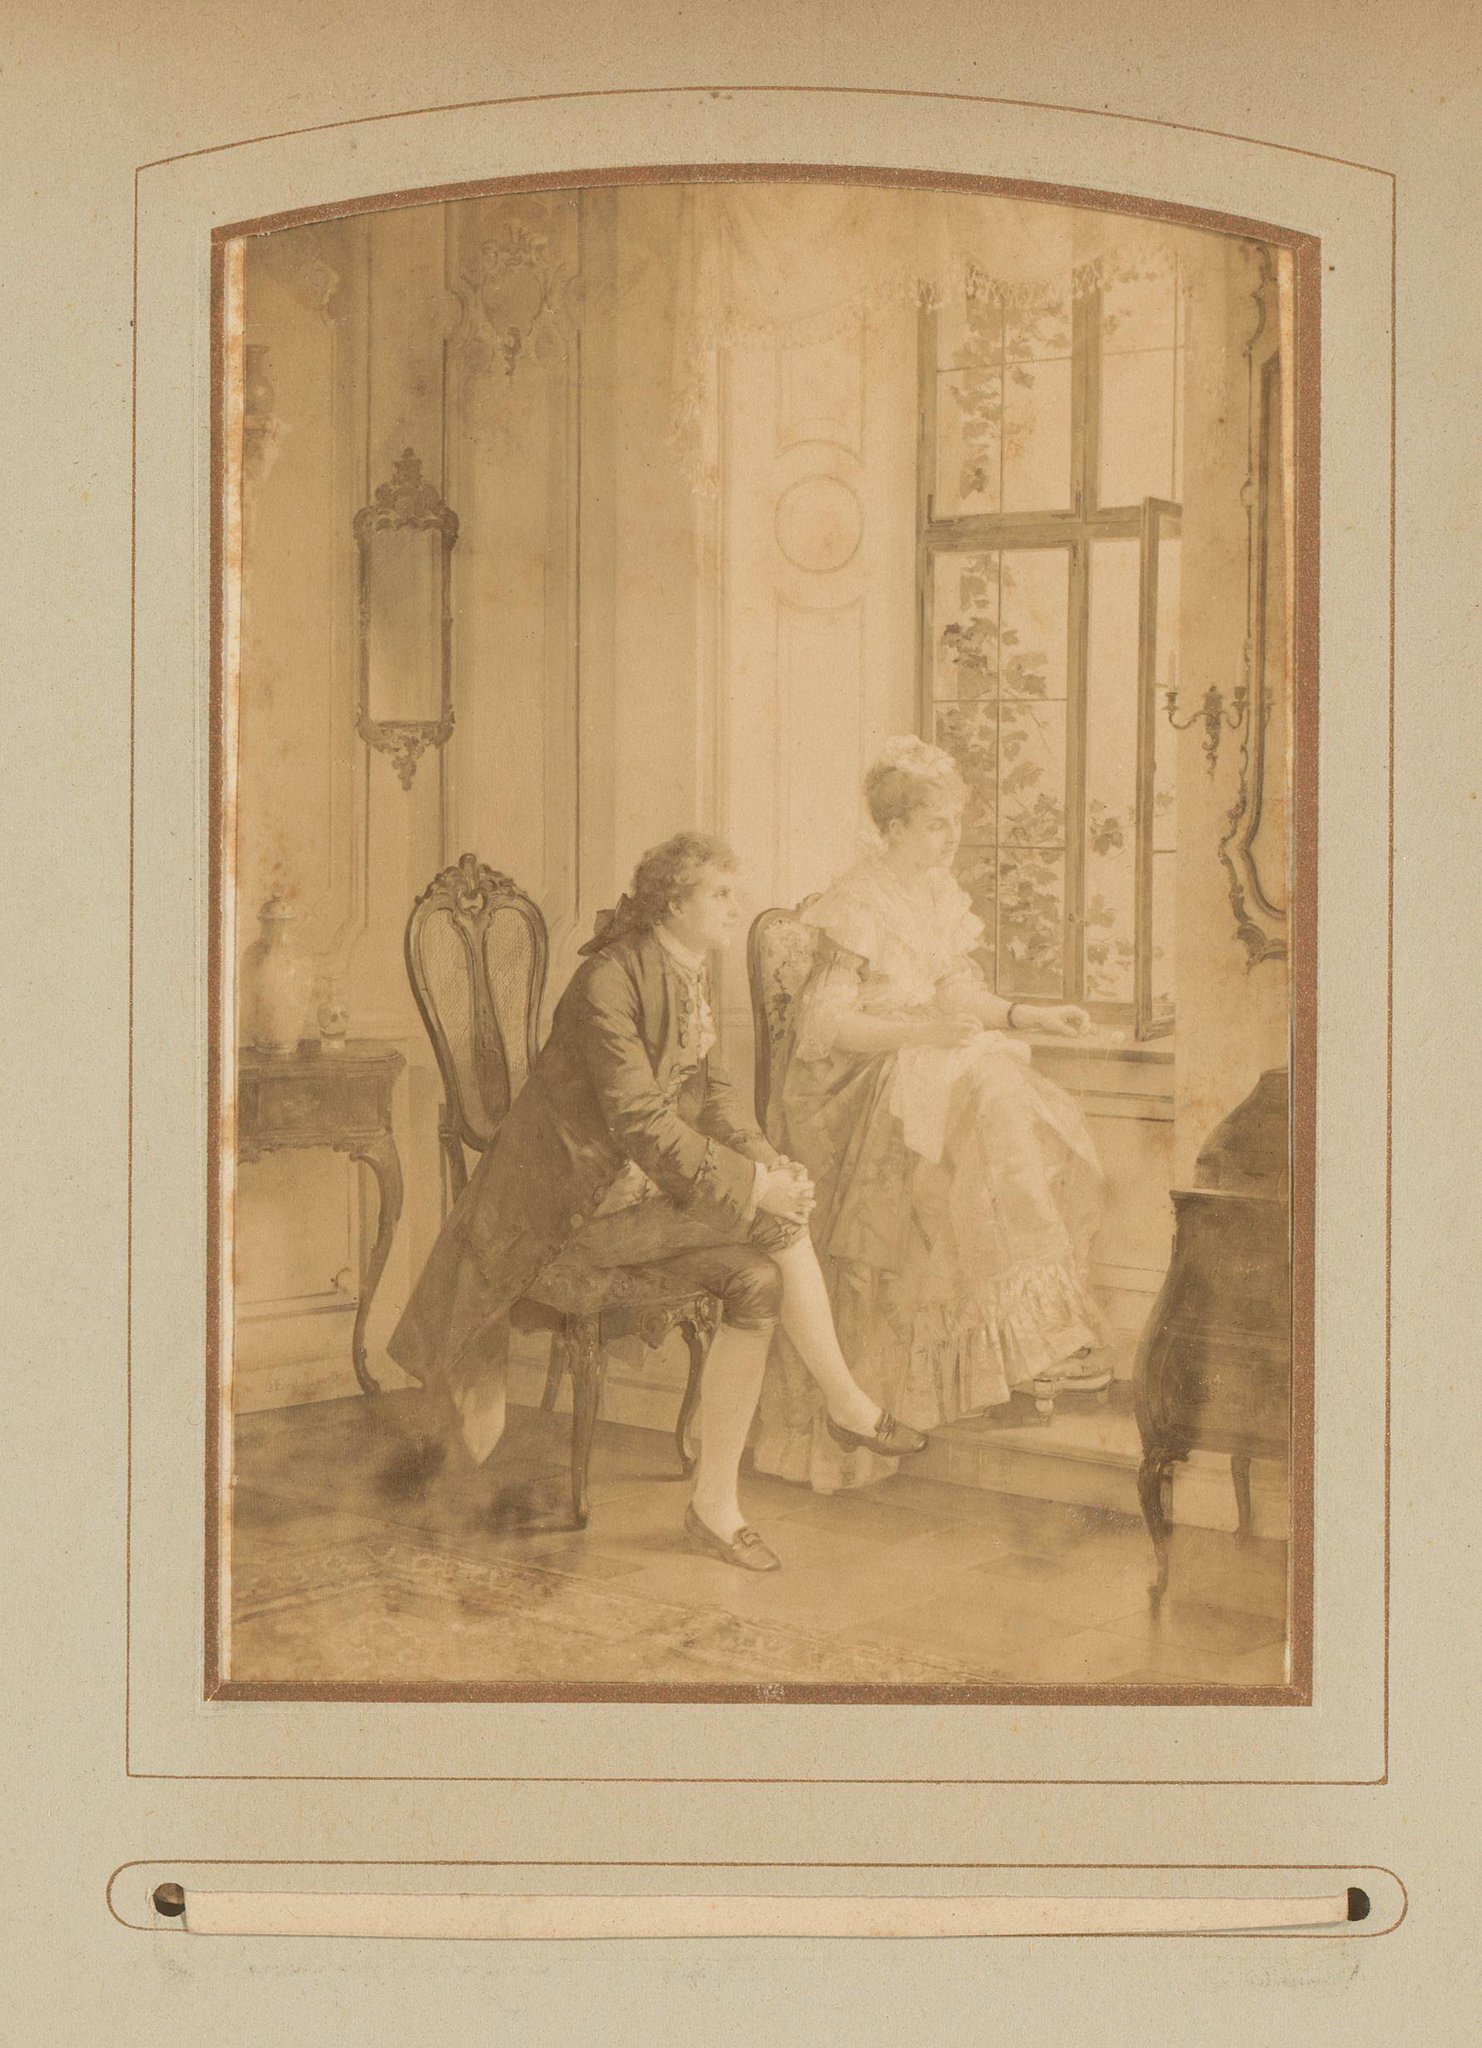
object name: album leaf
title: Fotoreproductie van een schilderij van een man en een vrouw die voor een raam zitten en naar buiten kijken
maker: franz seraph hanfstaengl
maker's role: painter, print maker, printer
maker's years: 1804-1877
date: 1860-1900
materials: cardboard, photographic support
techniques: albumen print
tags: adult woman, adult man, living-room, parlour, sitting-room, closed window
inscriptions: name: ‘Hanfstaengel/ [...]’